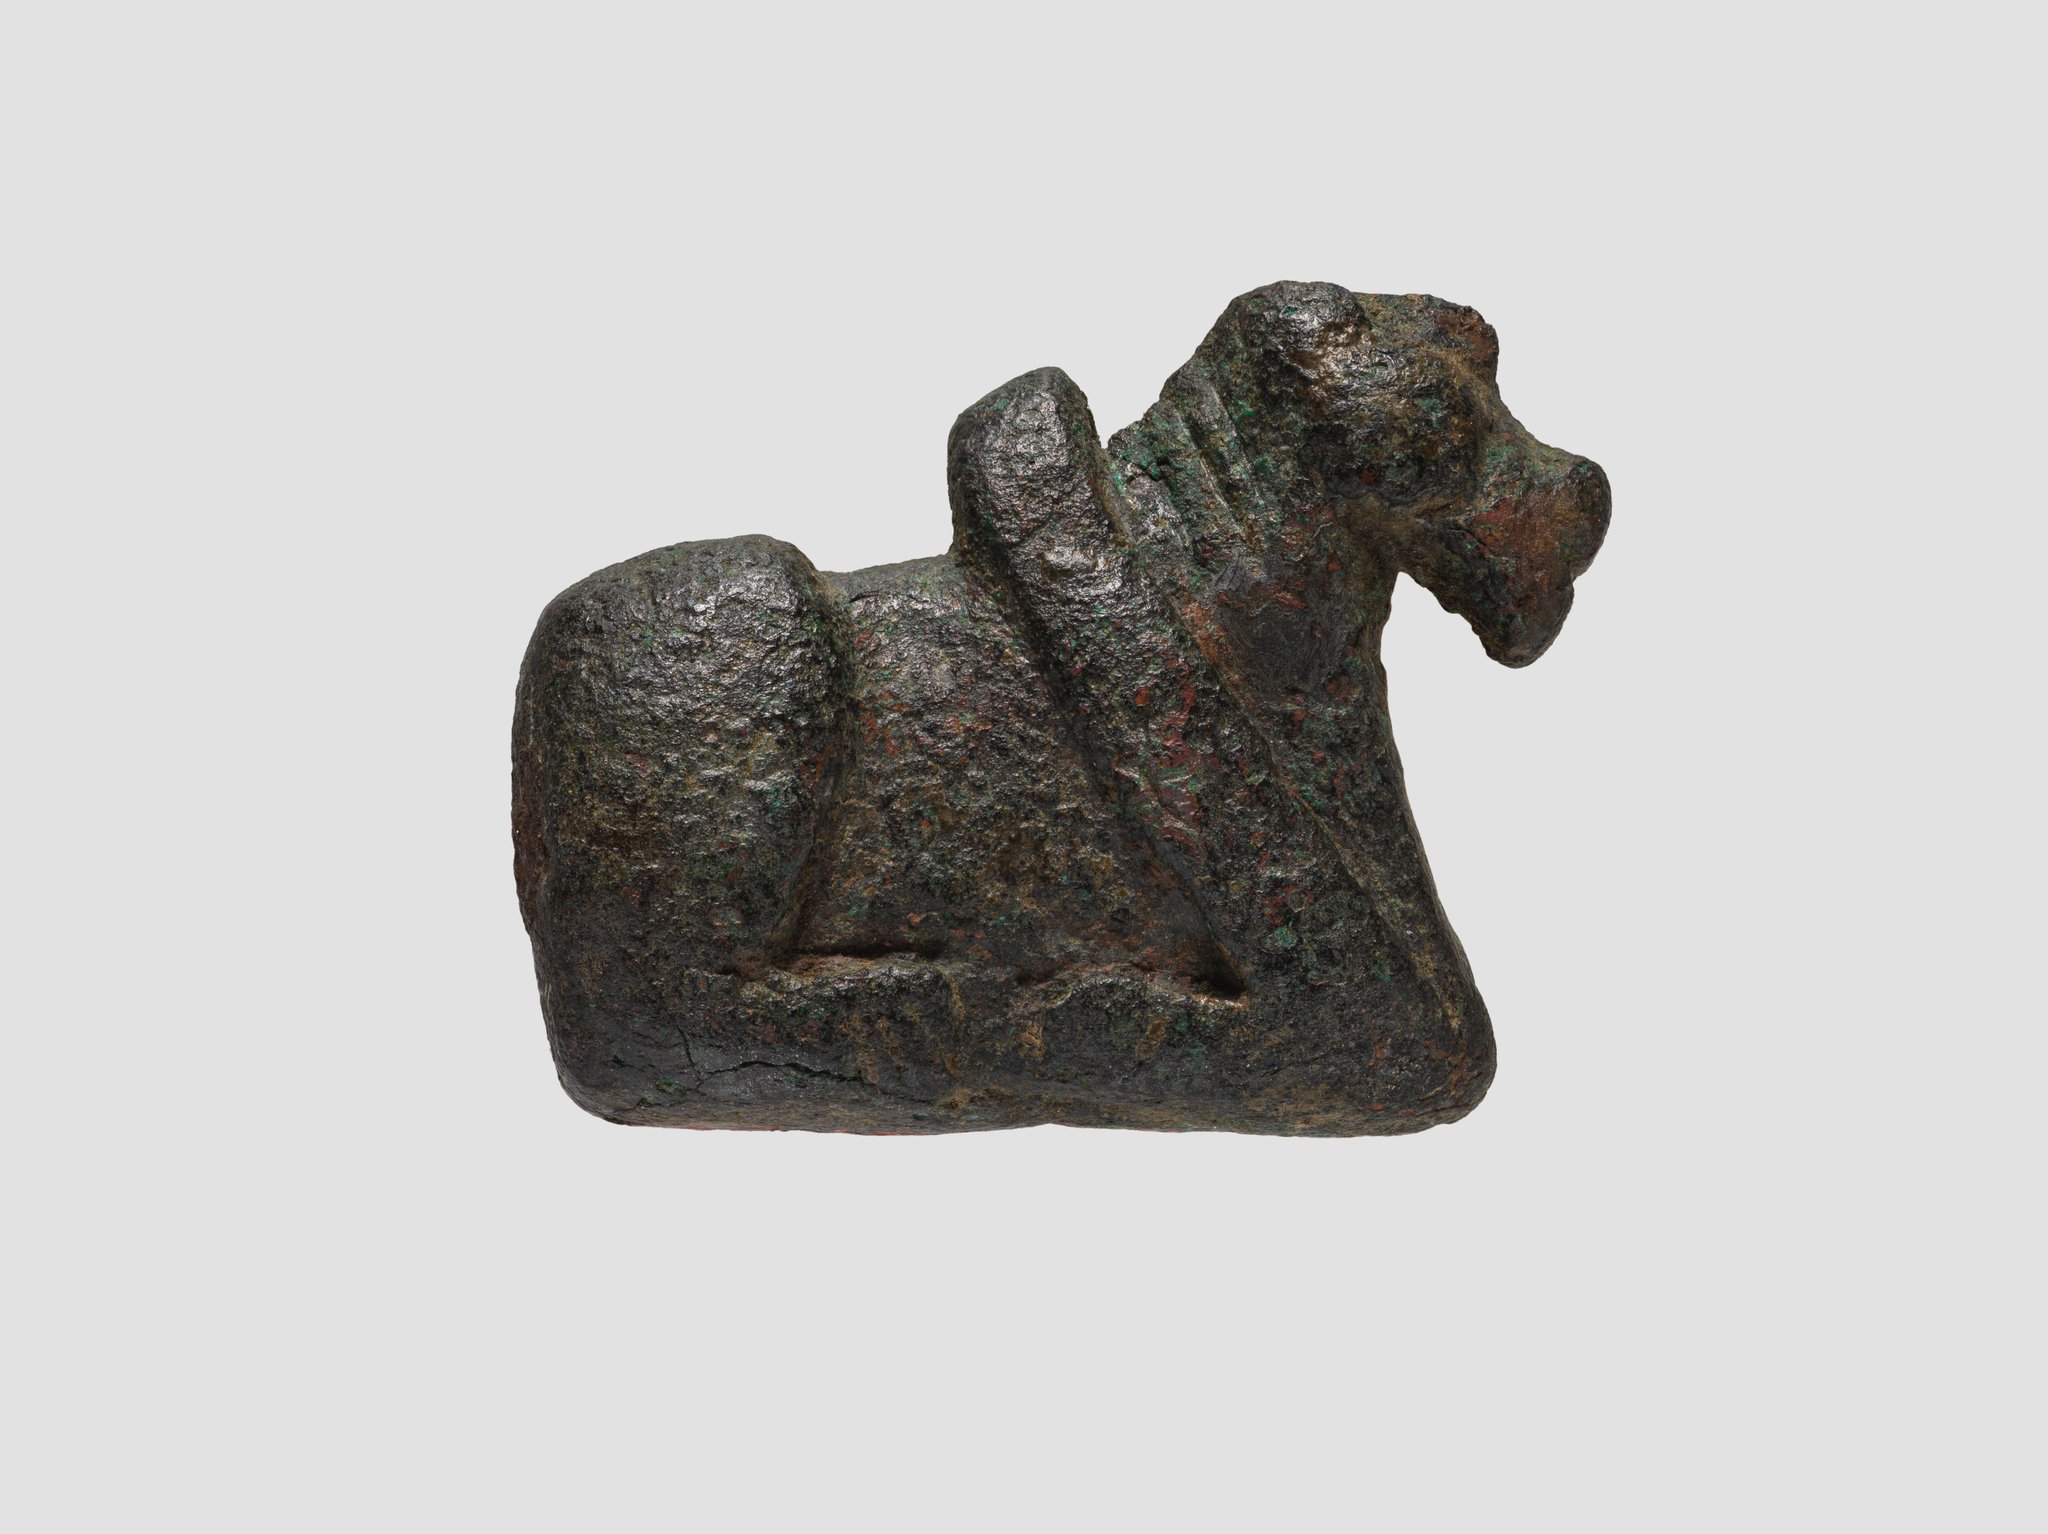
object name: pin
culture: iranian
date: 800-601 BCE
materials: bronze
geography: iran, probably from luristan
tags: animals